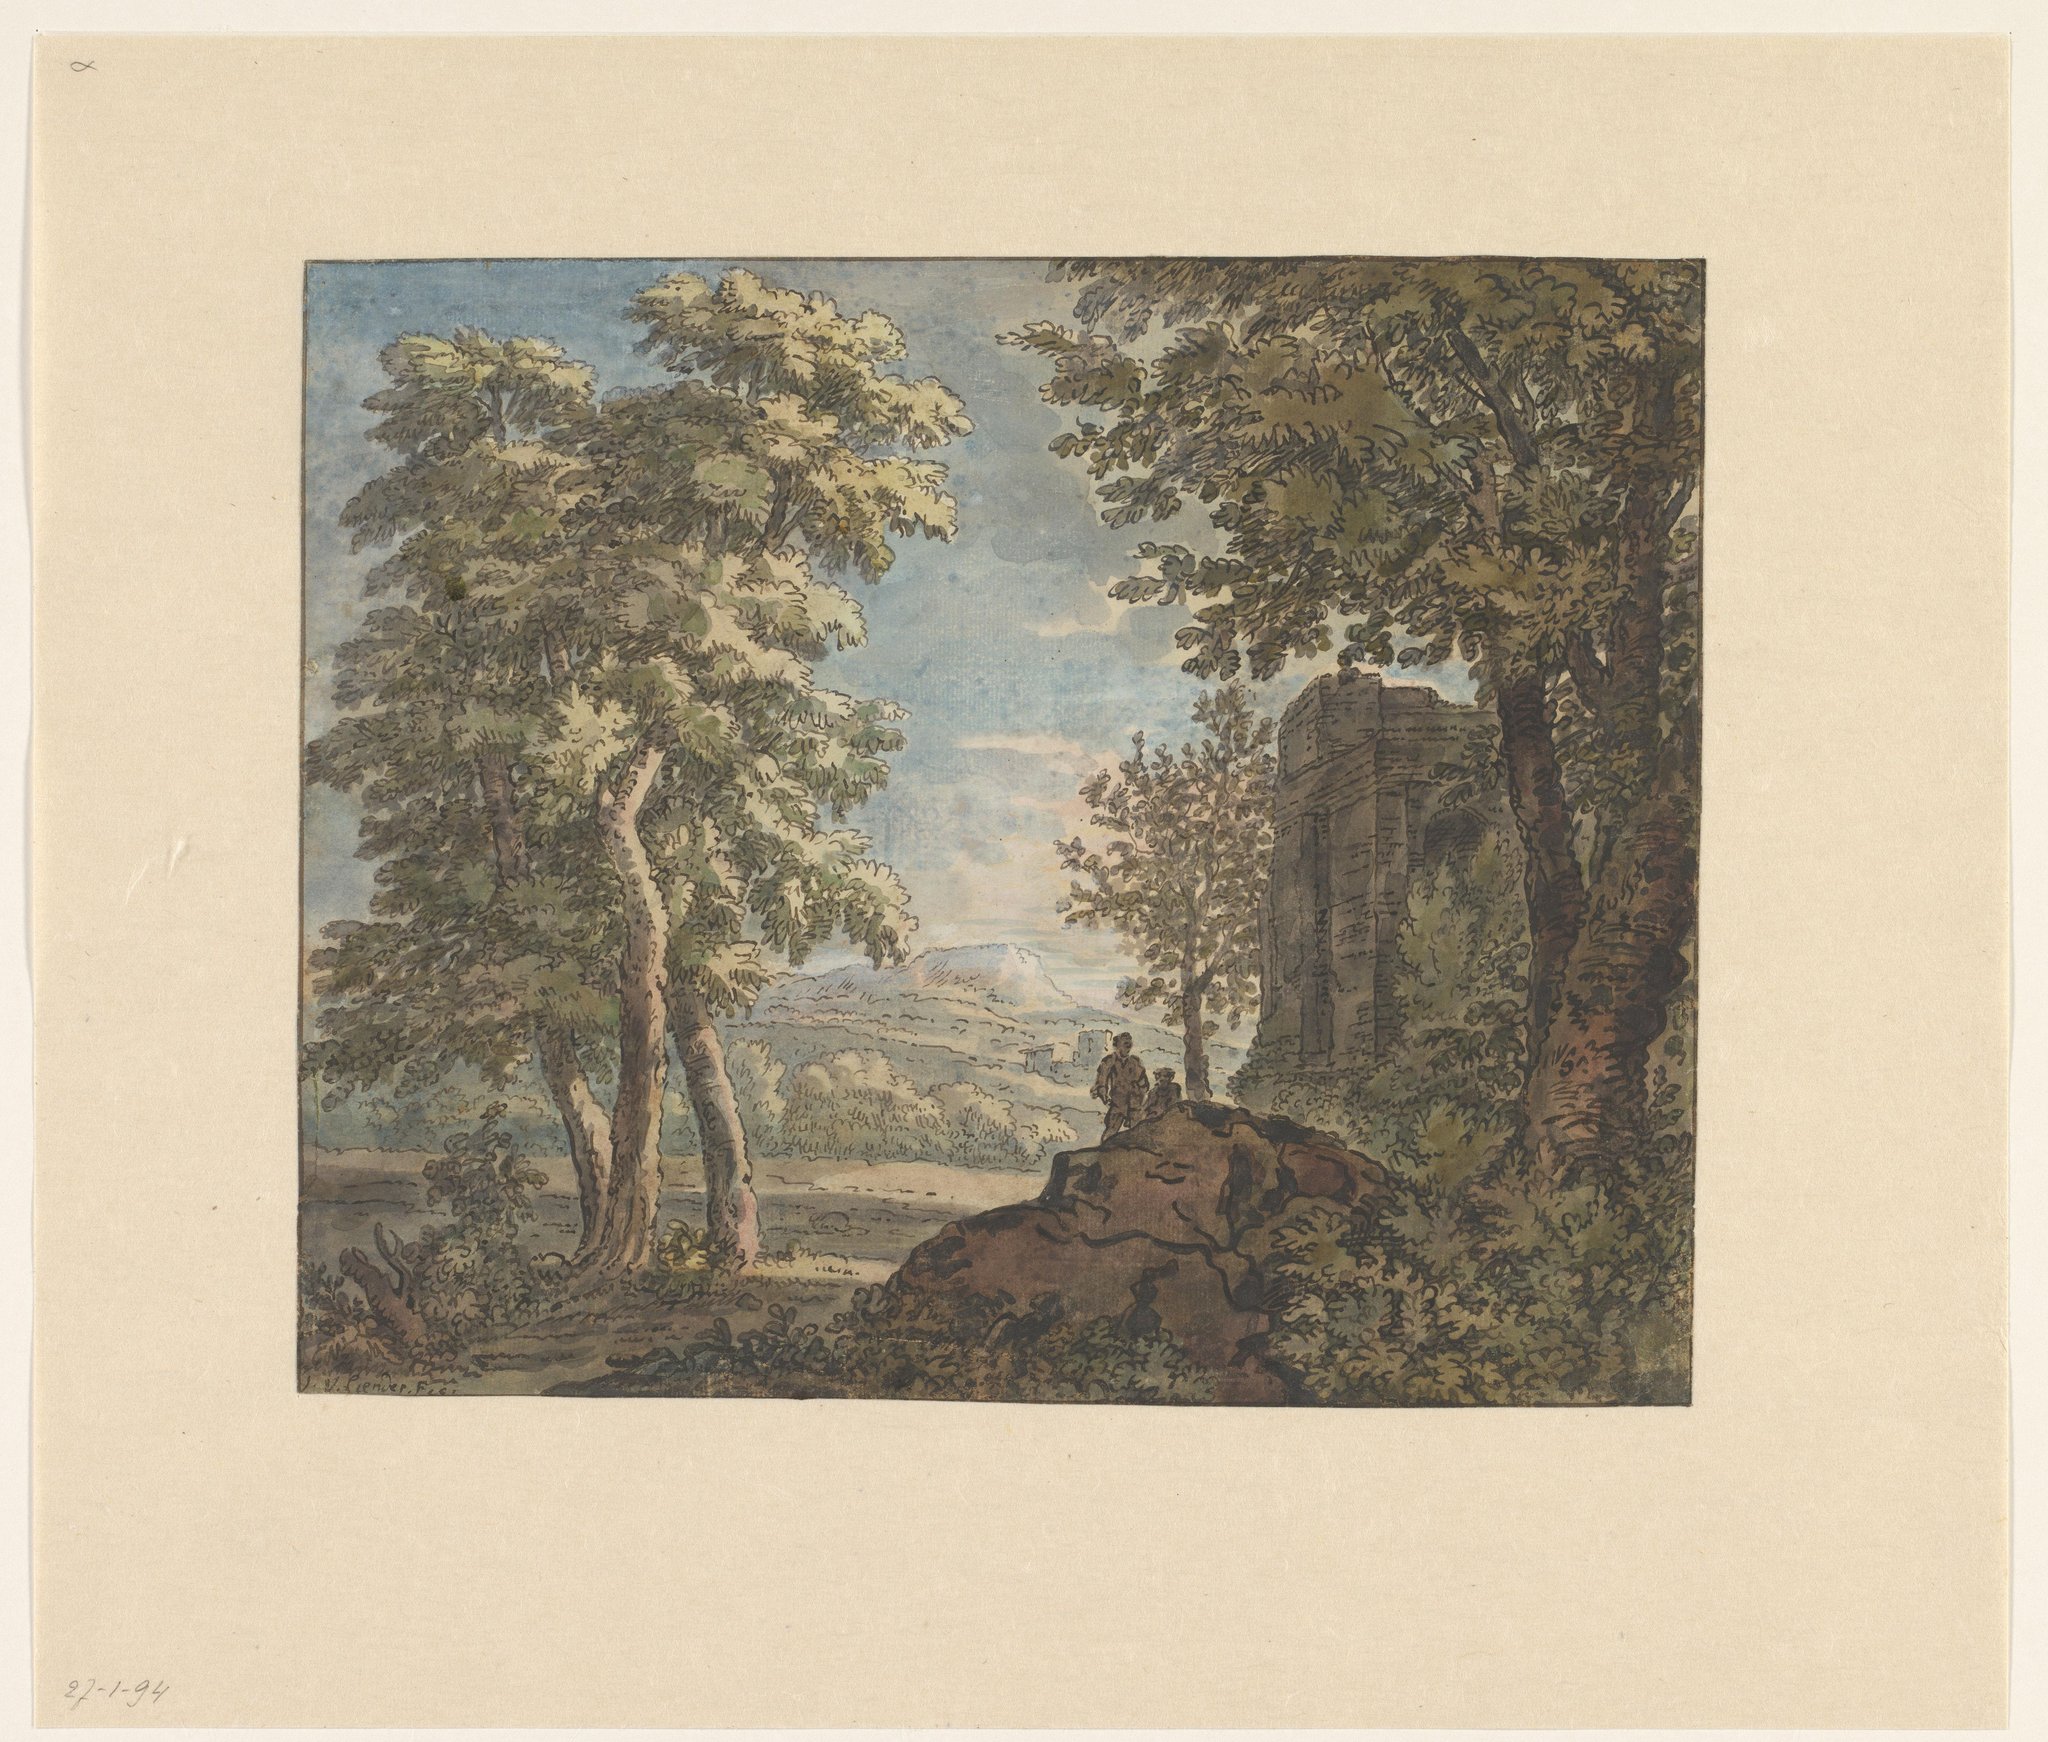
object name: watercolor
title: Arcadisch landschap met antiek bouwval en twee mannen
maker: jacob van liender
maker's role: draughtsman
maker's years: 1696-1759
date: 1706-1759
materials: ink, paper, watercolor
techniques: brush, pen